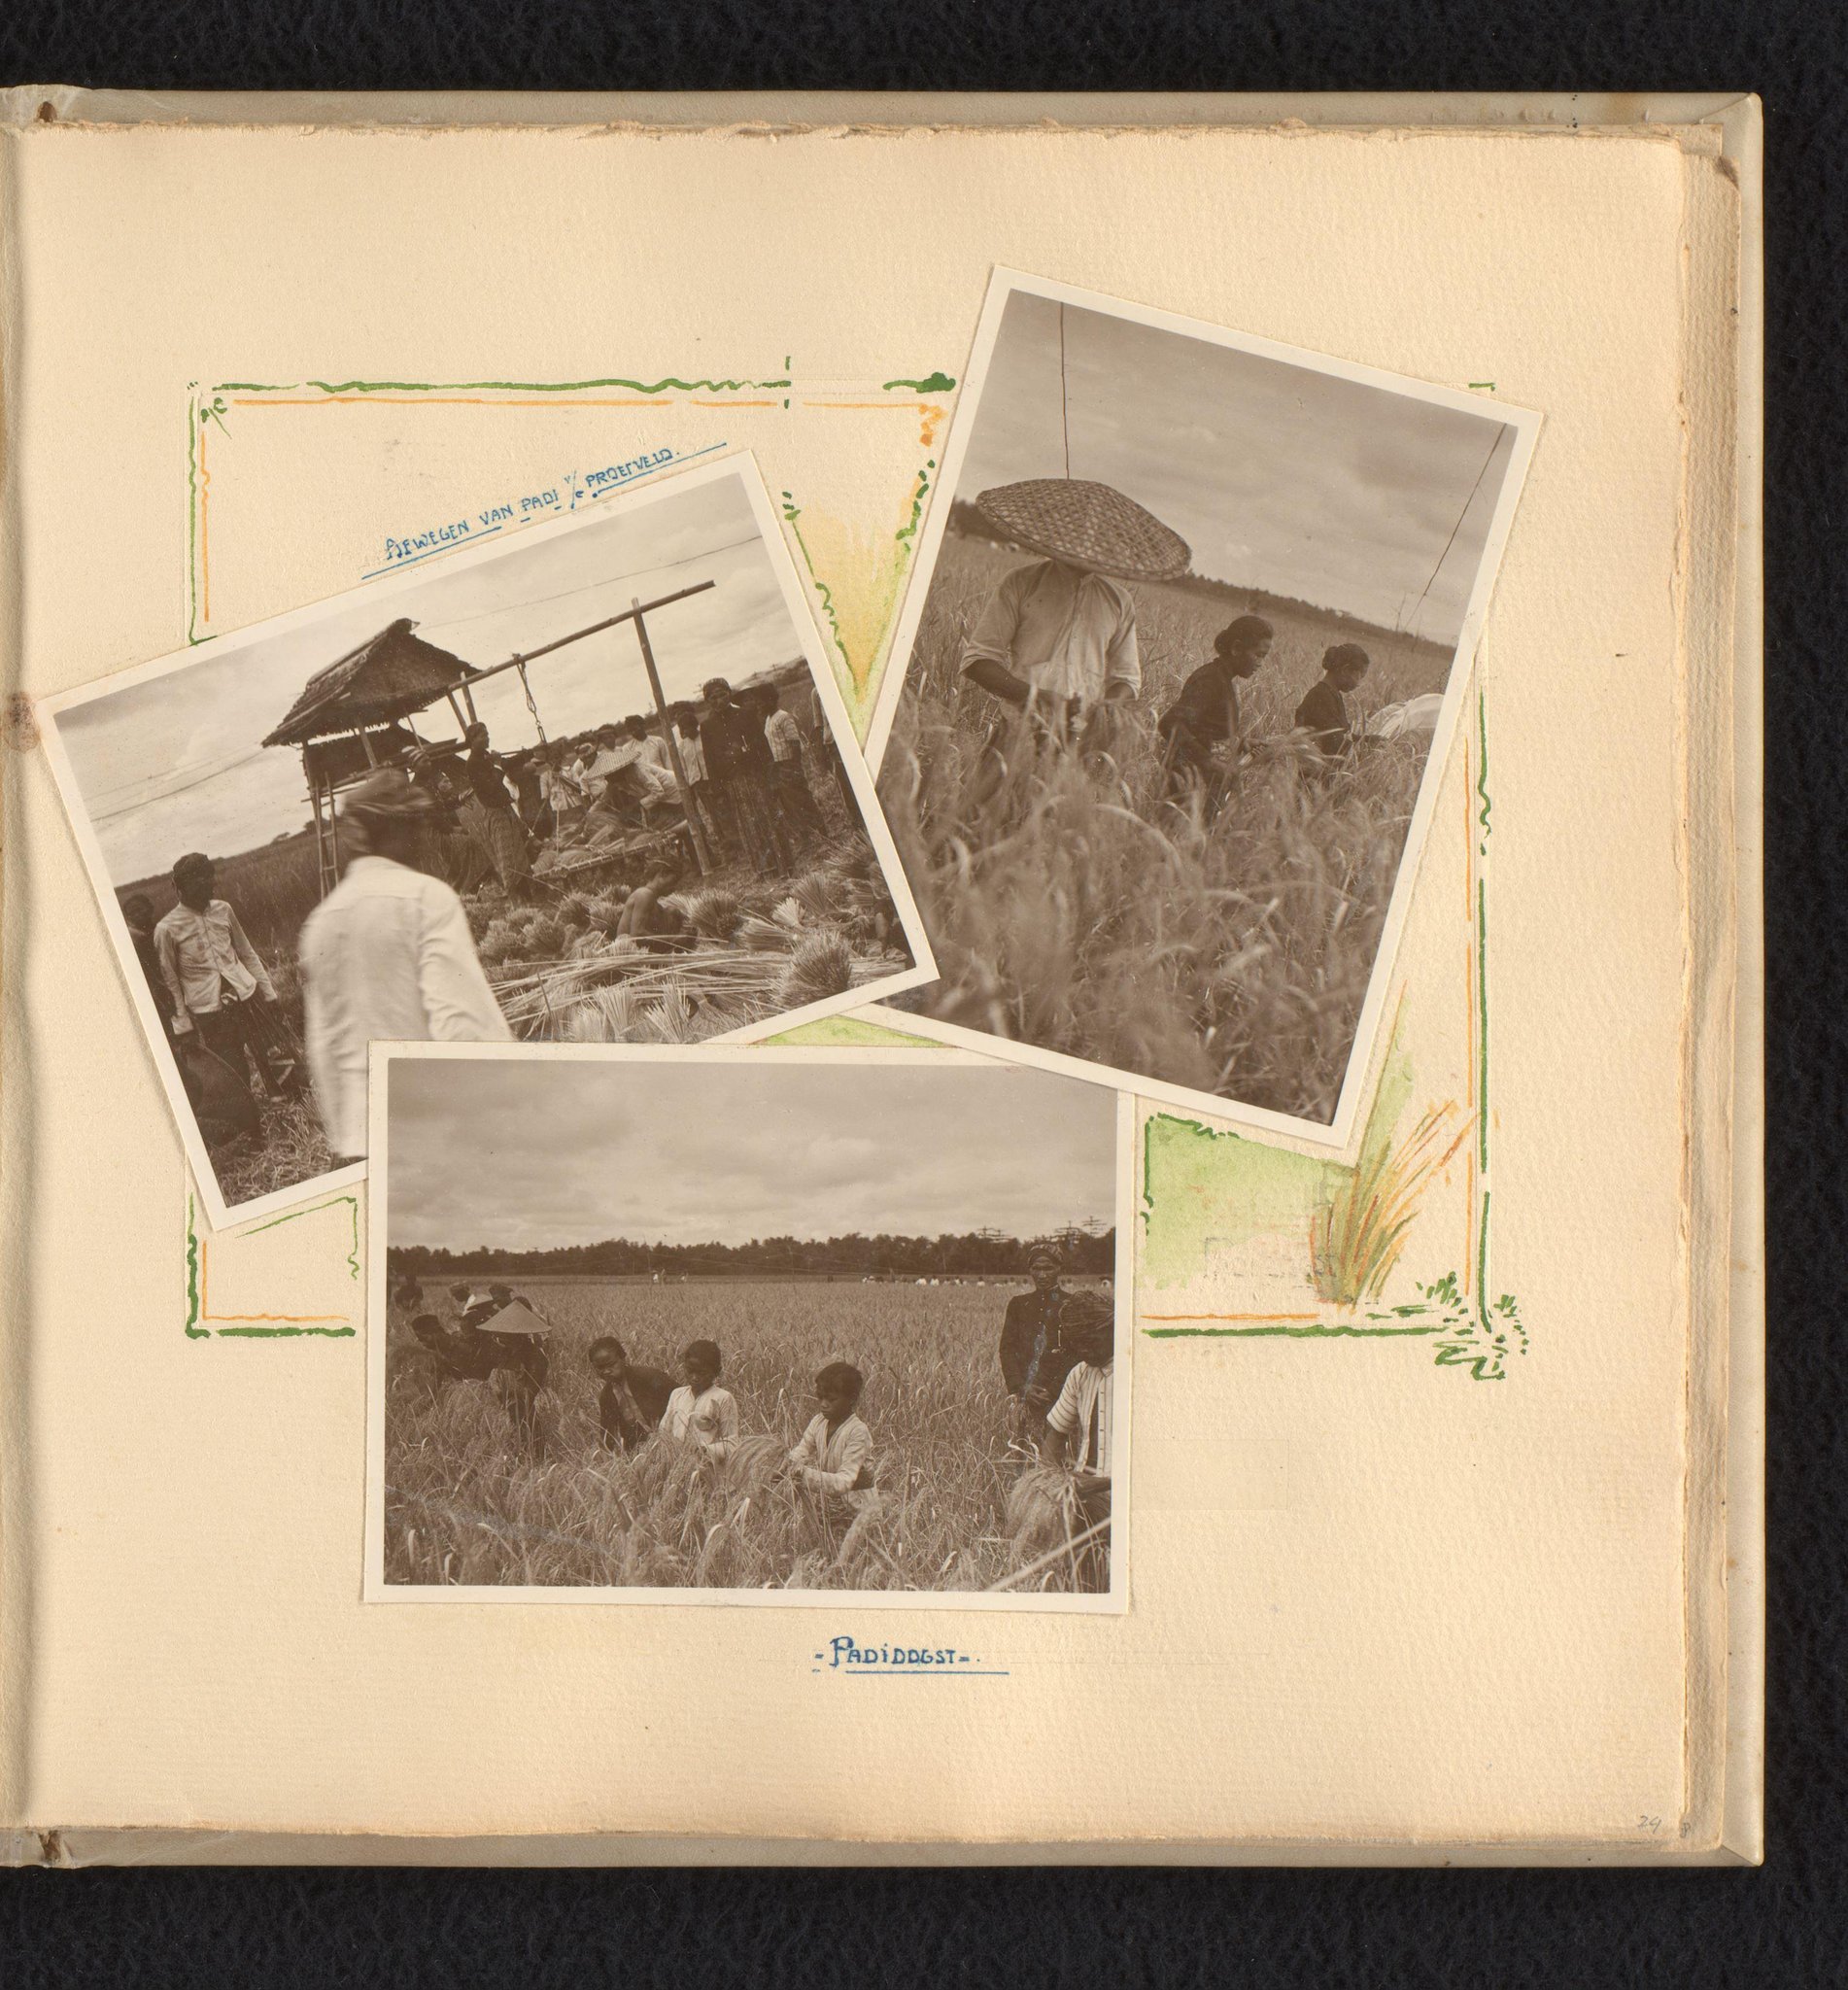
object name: photograph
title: Rijstoogst in Grobogan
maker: Anonymous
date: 1910-1928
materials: paper, photographic support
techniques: drawing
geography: grobogan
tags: harvest, cereal, grain, corn (grass with grains, grown for food, e.g.: wheat, rice, rye, oats, maize, buckwheat, millet)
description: Albumblad met drie foto's van de rijstoogst in Grobogan. Het blad is versierd met een rijstplant en randwerk om de foto's. Onderdeel van het fotoalbum aangeboden aan J. Habbema door het Binnenlandsch Bestuur Corps van het Regentschap Grobogan, bij het beëindigen van zijn bestuur over het Regentschap, waarschijnlijk in 1928.